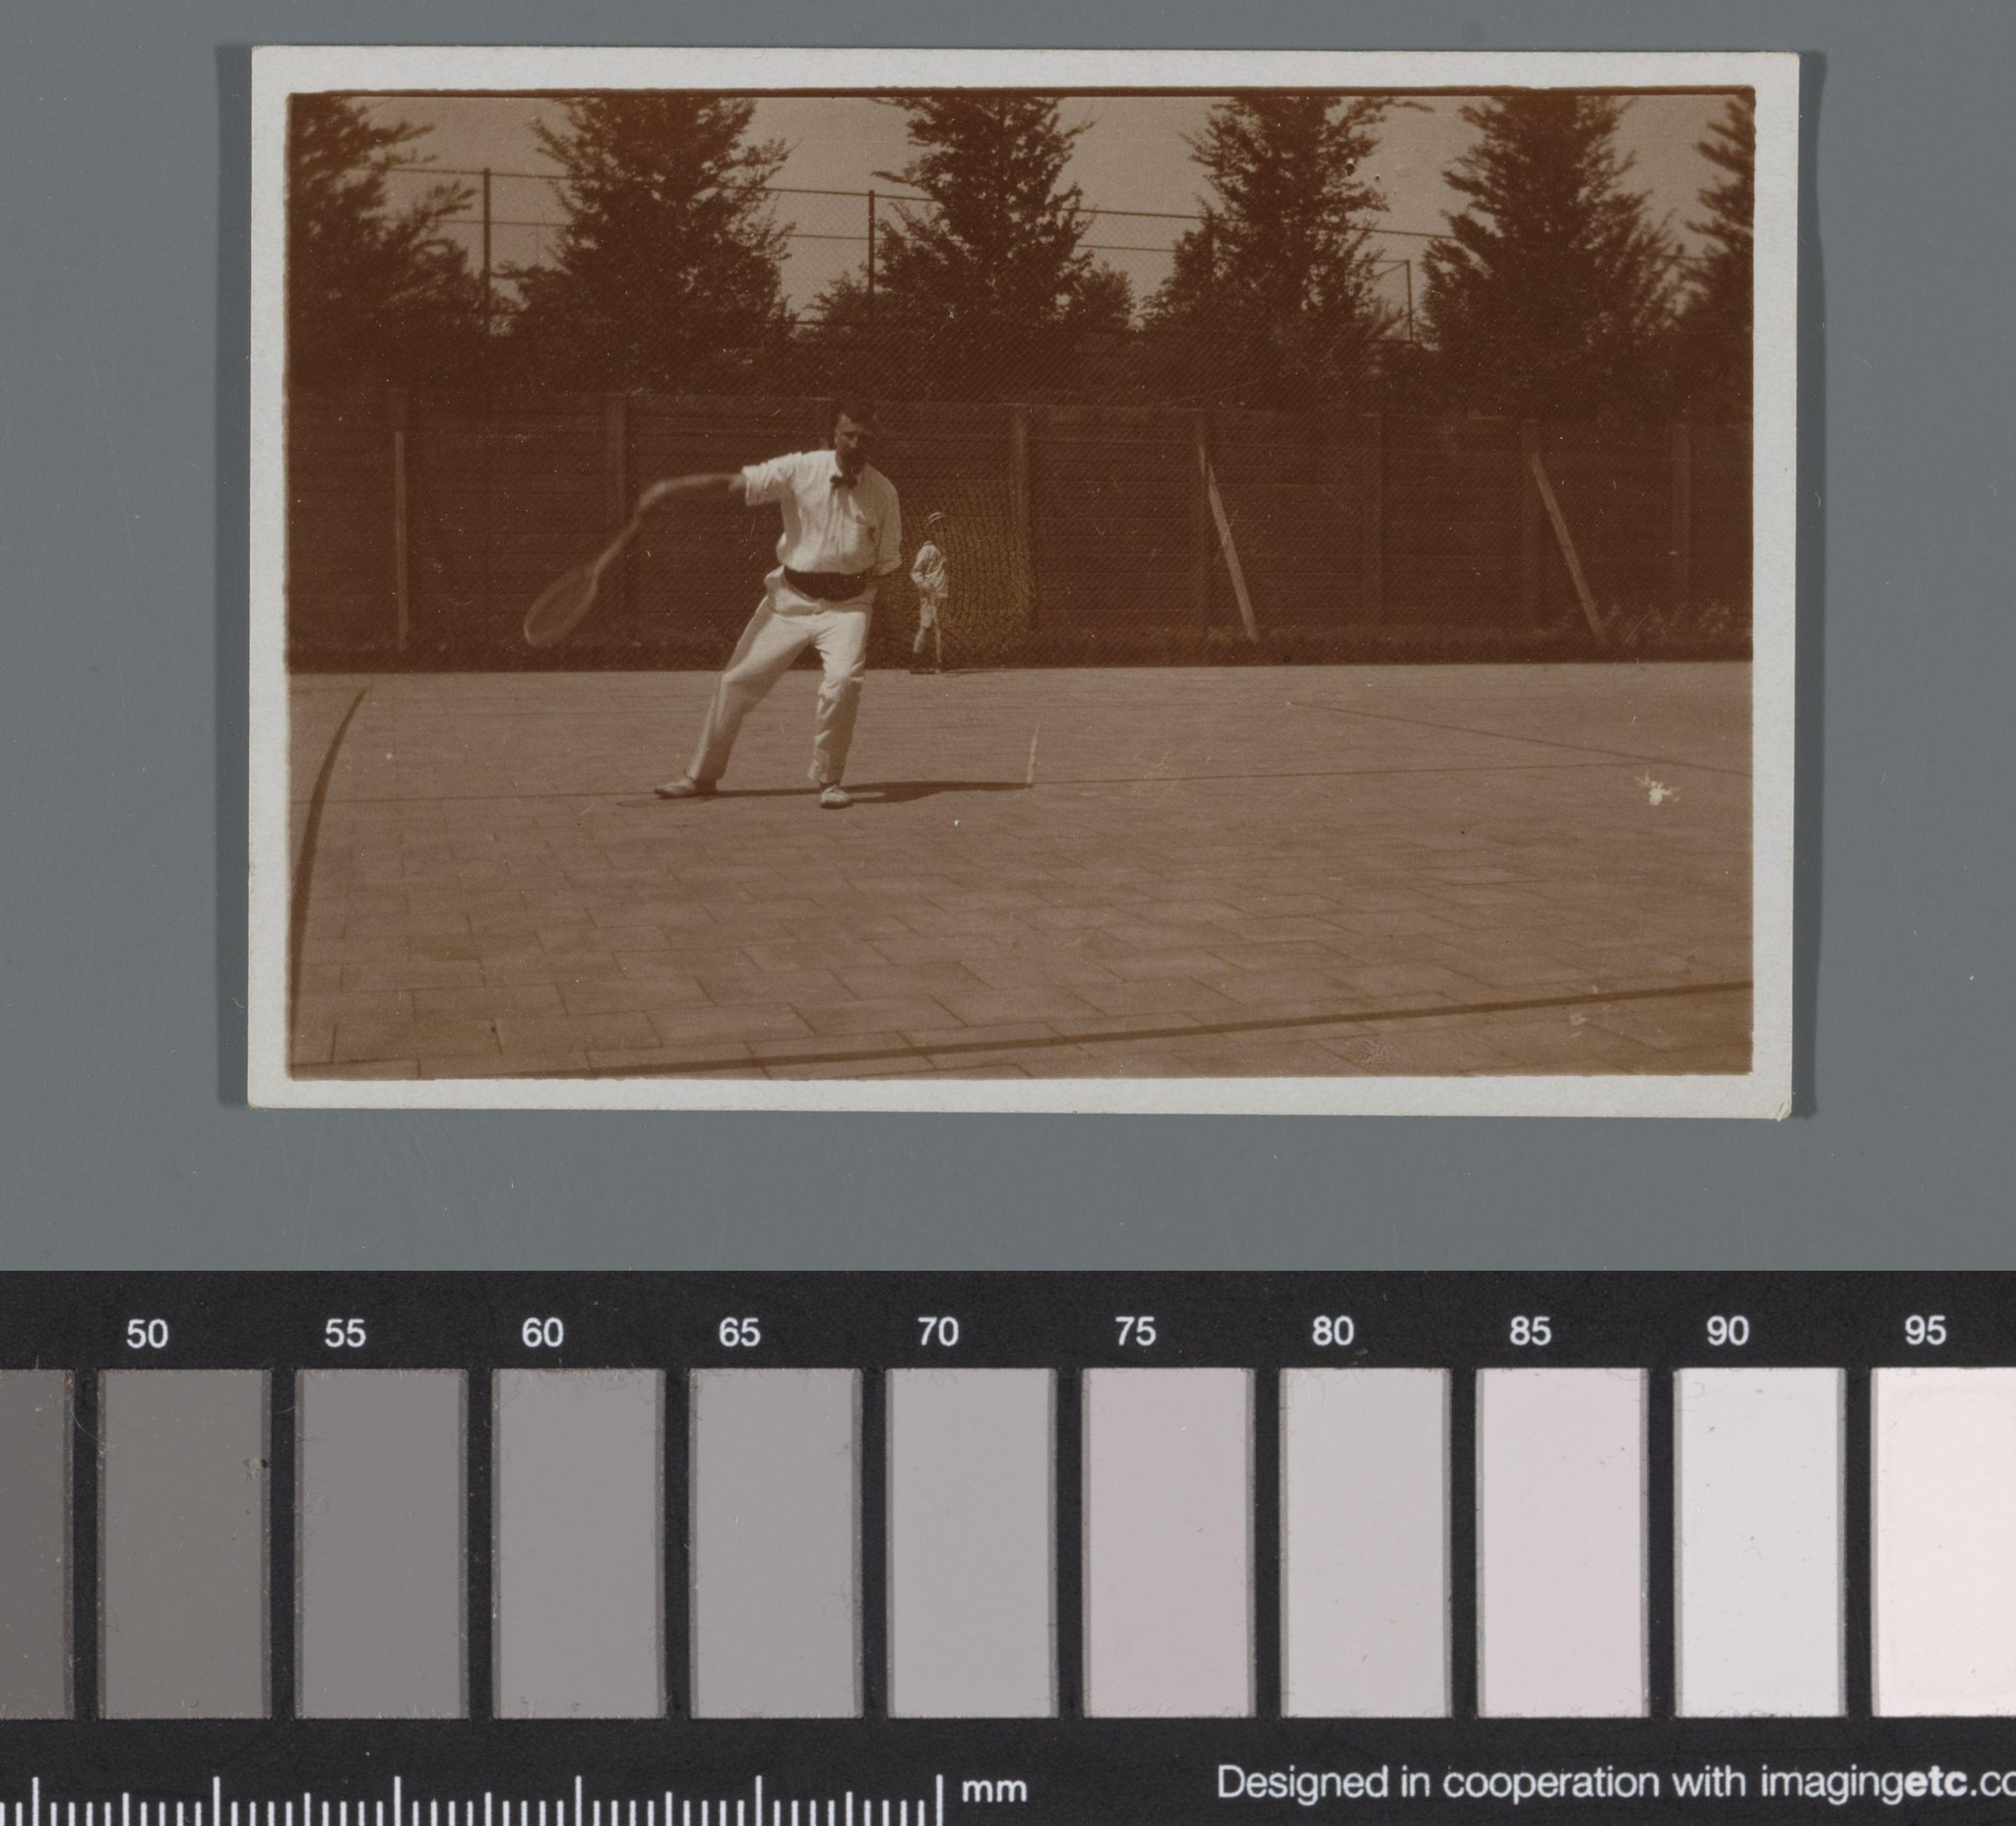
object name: photograph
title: Onbekende tennisspeler op de tennisbaan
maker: cornelia hendrika jonker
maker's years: 1874-1924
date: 1917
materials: photographic support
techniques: collodion silver print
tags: tennis, lawn-tennis, historical persons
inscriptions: annotation: ‘28 mei 1917’, number: ‘2’